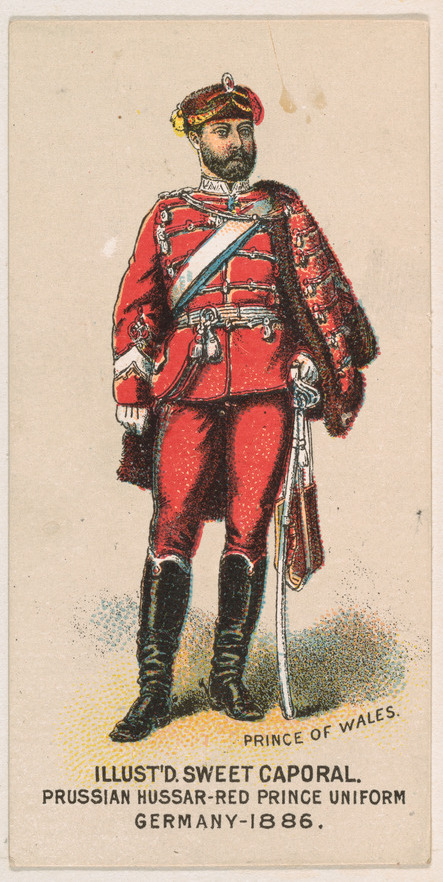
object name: print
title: Prussian Hussar, Red Prince Uniform, Germany, 1886, from the Military Series (N224) issued by Kinney Tobacco Company to promote Sweet Caporal Cigarettes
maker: kinney brothers tobacco company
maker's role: publisher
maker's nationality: american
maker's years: 1869-2011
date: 1888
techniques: color lithograph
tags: military,weapons,men